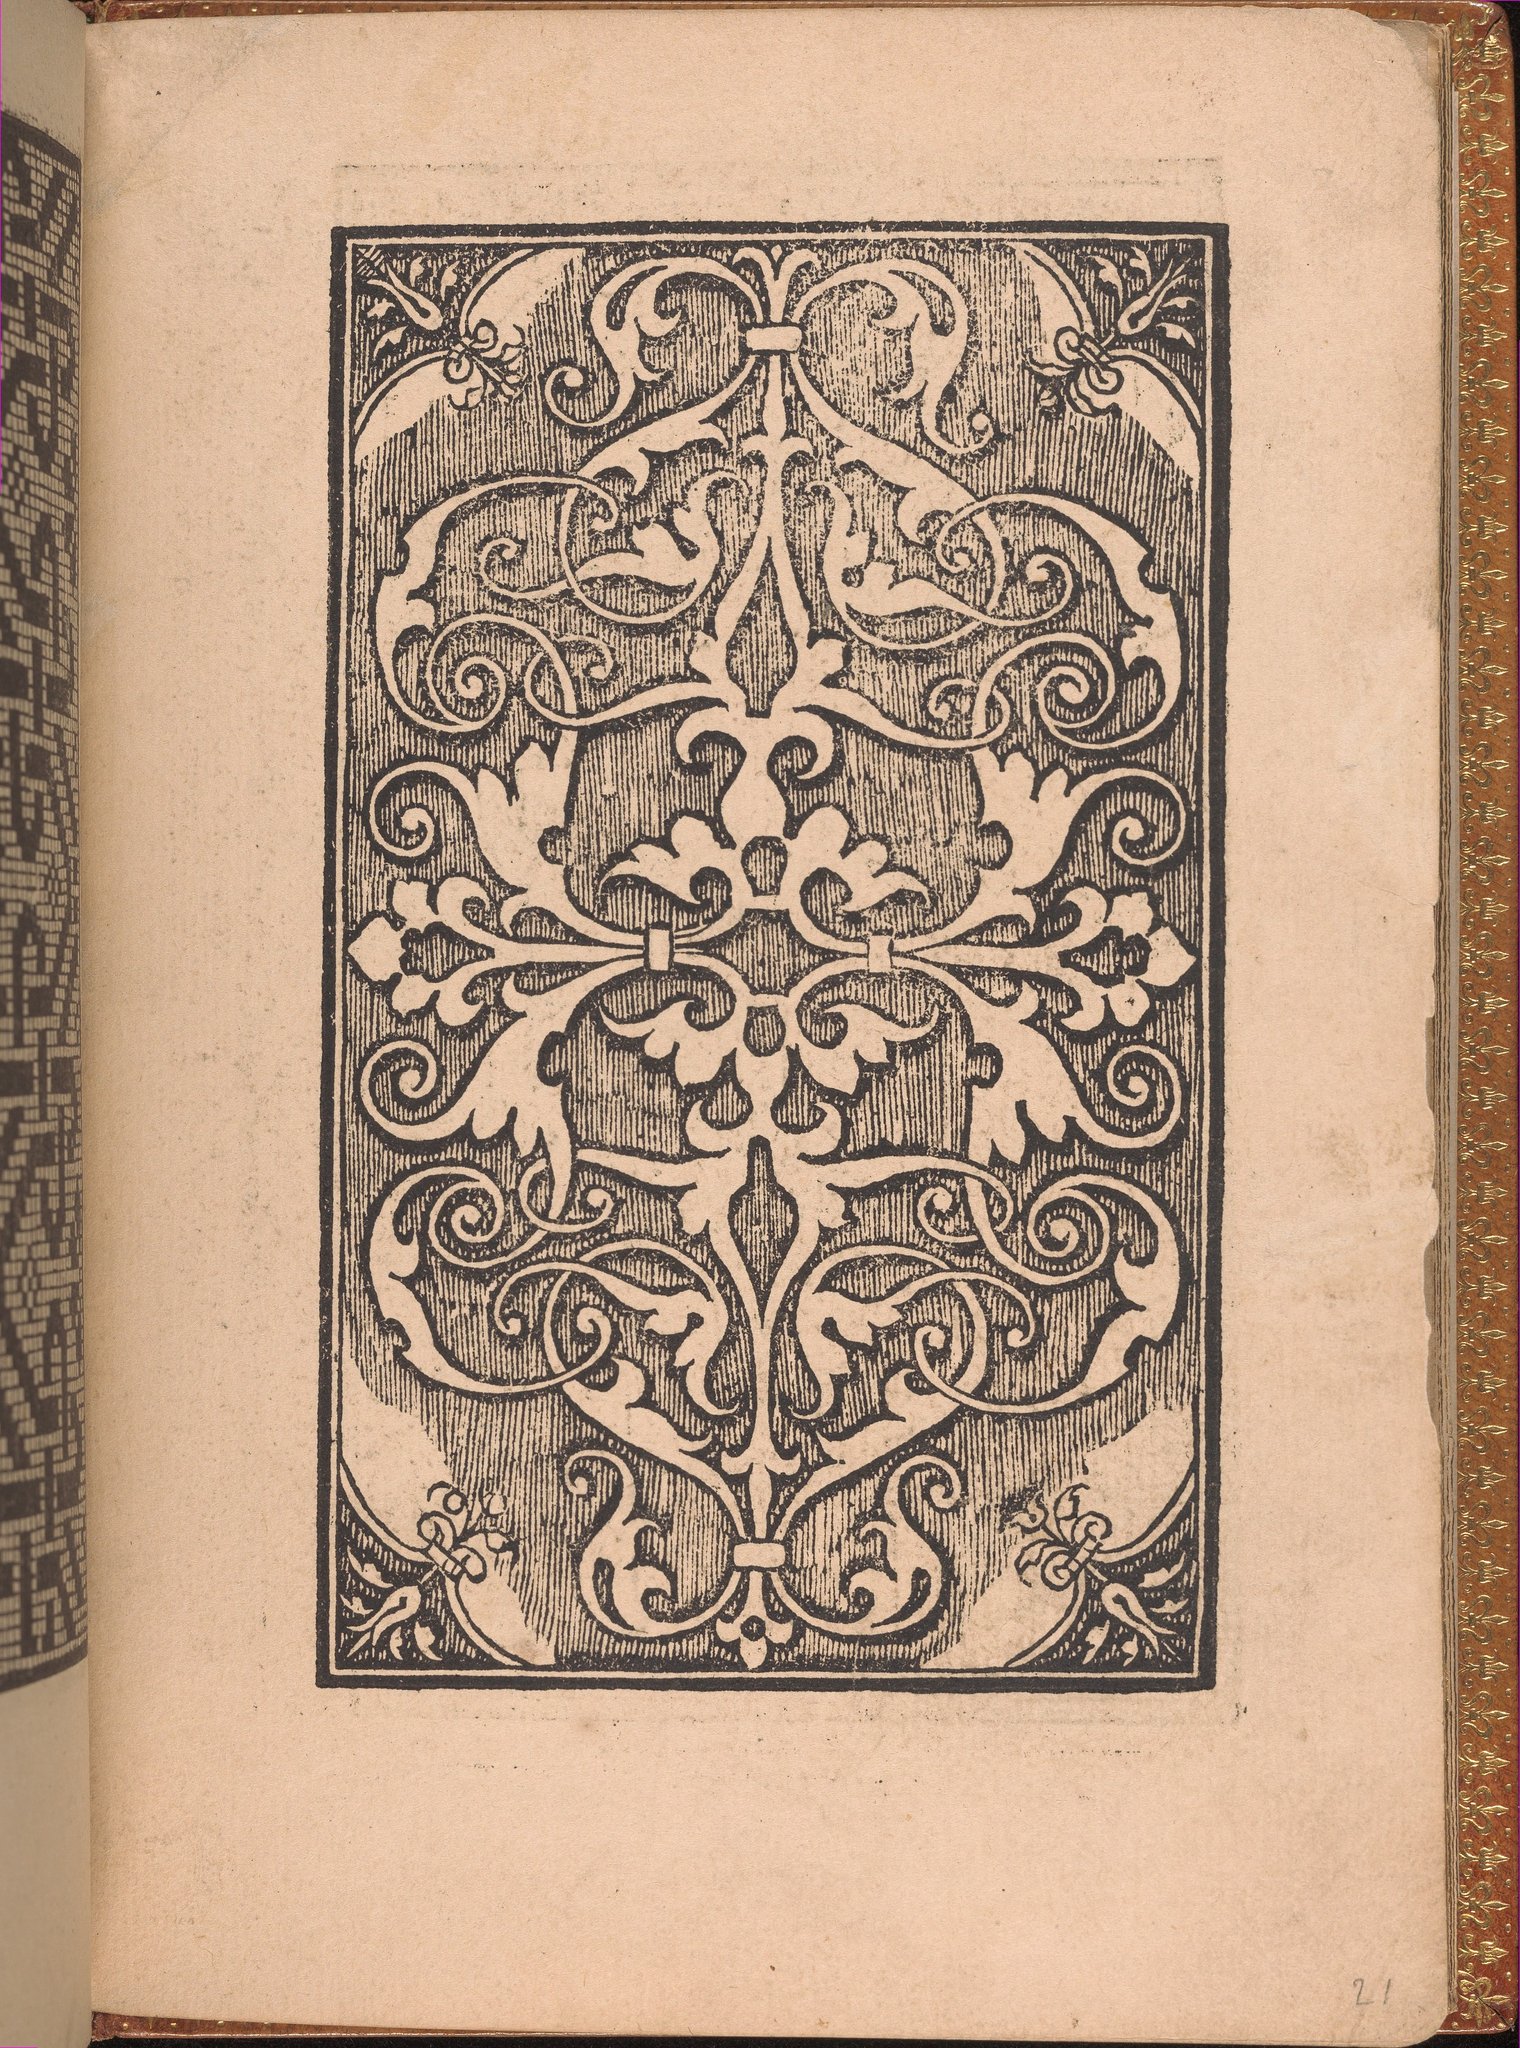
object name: book print ornament architecture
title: Convivio delle Belle Donne, page 21 (recto)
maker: nicolò zoppino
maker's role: publisher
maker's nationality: italian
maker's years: 1478-1544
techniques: woodcut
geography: italy